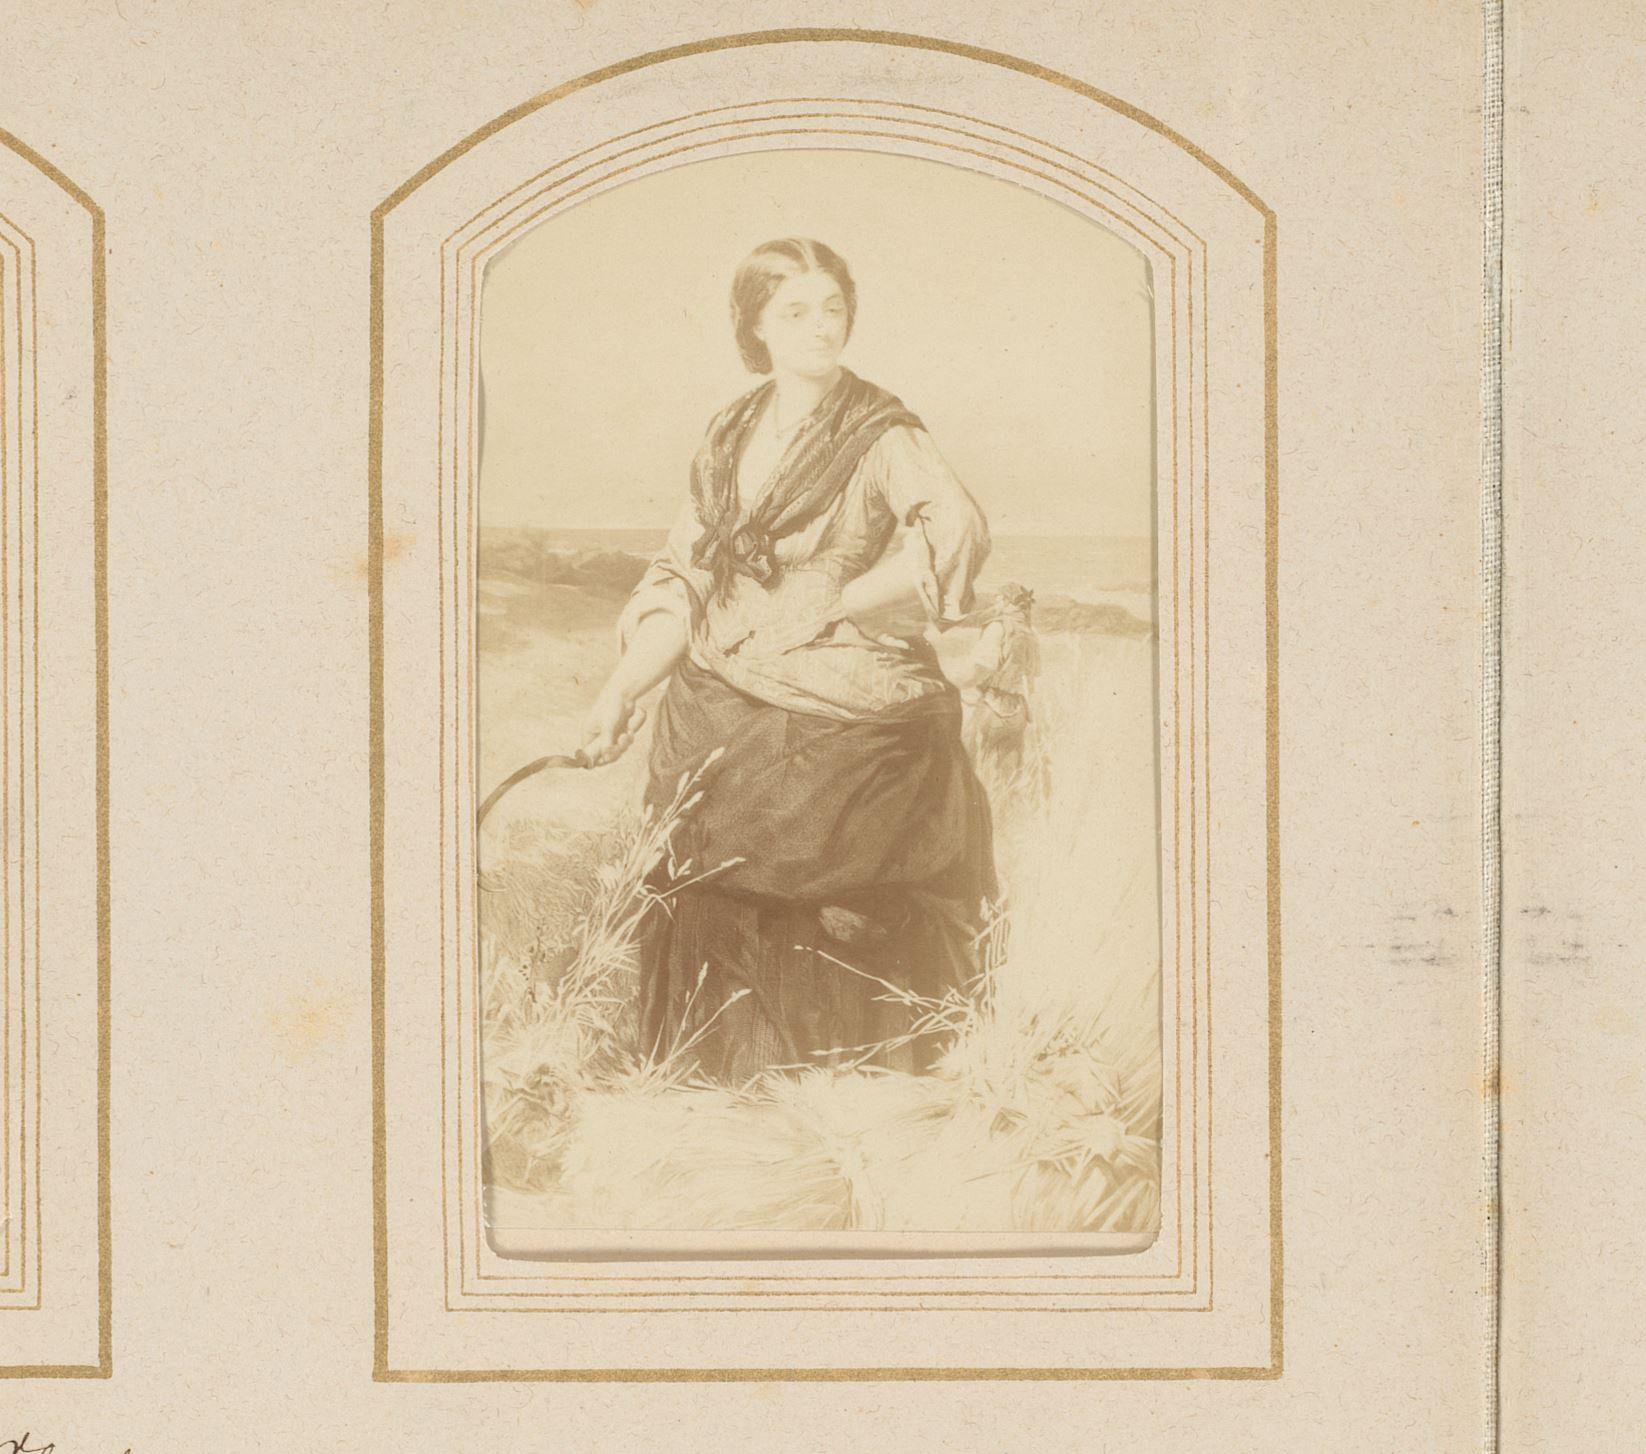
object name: carte de visite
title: Fotoreproductie van La moissonneuse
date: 1870-1890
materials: cardboard, photographic support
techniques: albumen print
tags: farmers - aa - female farmer, farmer's wife, reaping, picking, mowing ~ harvest, painting, drawing and the graphic arts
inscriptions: : ‘1806’, annotation: ‘[...]’